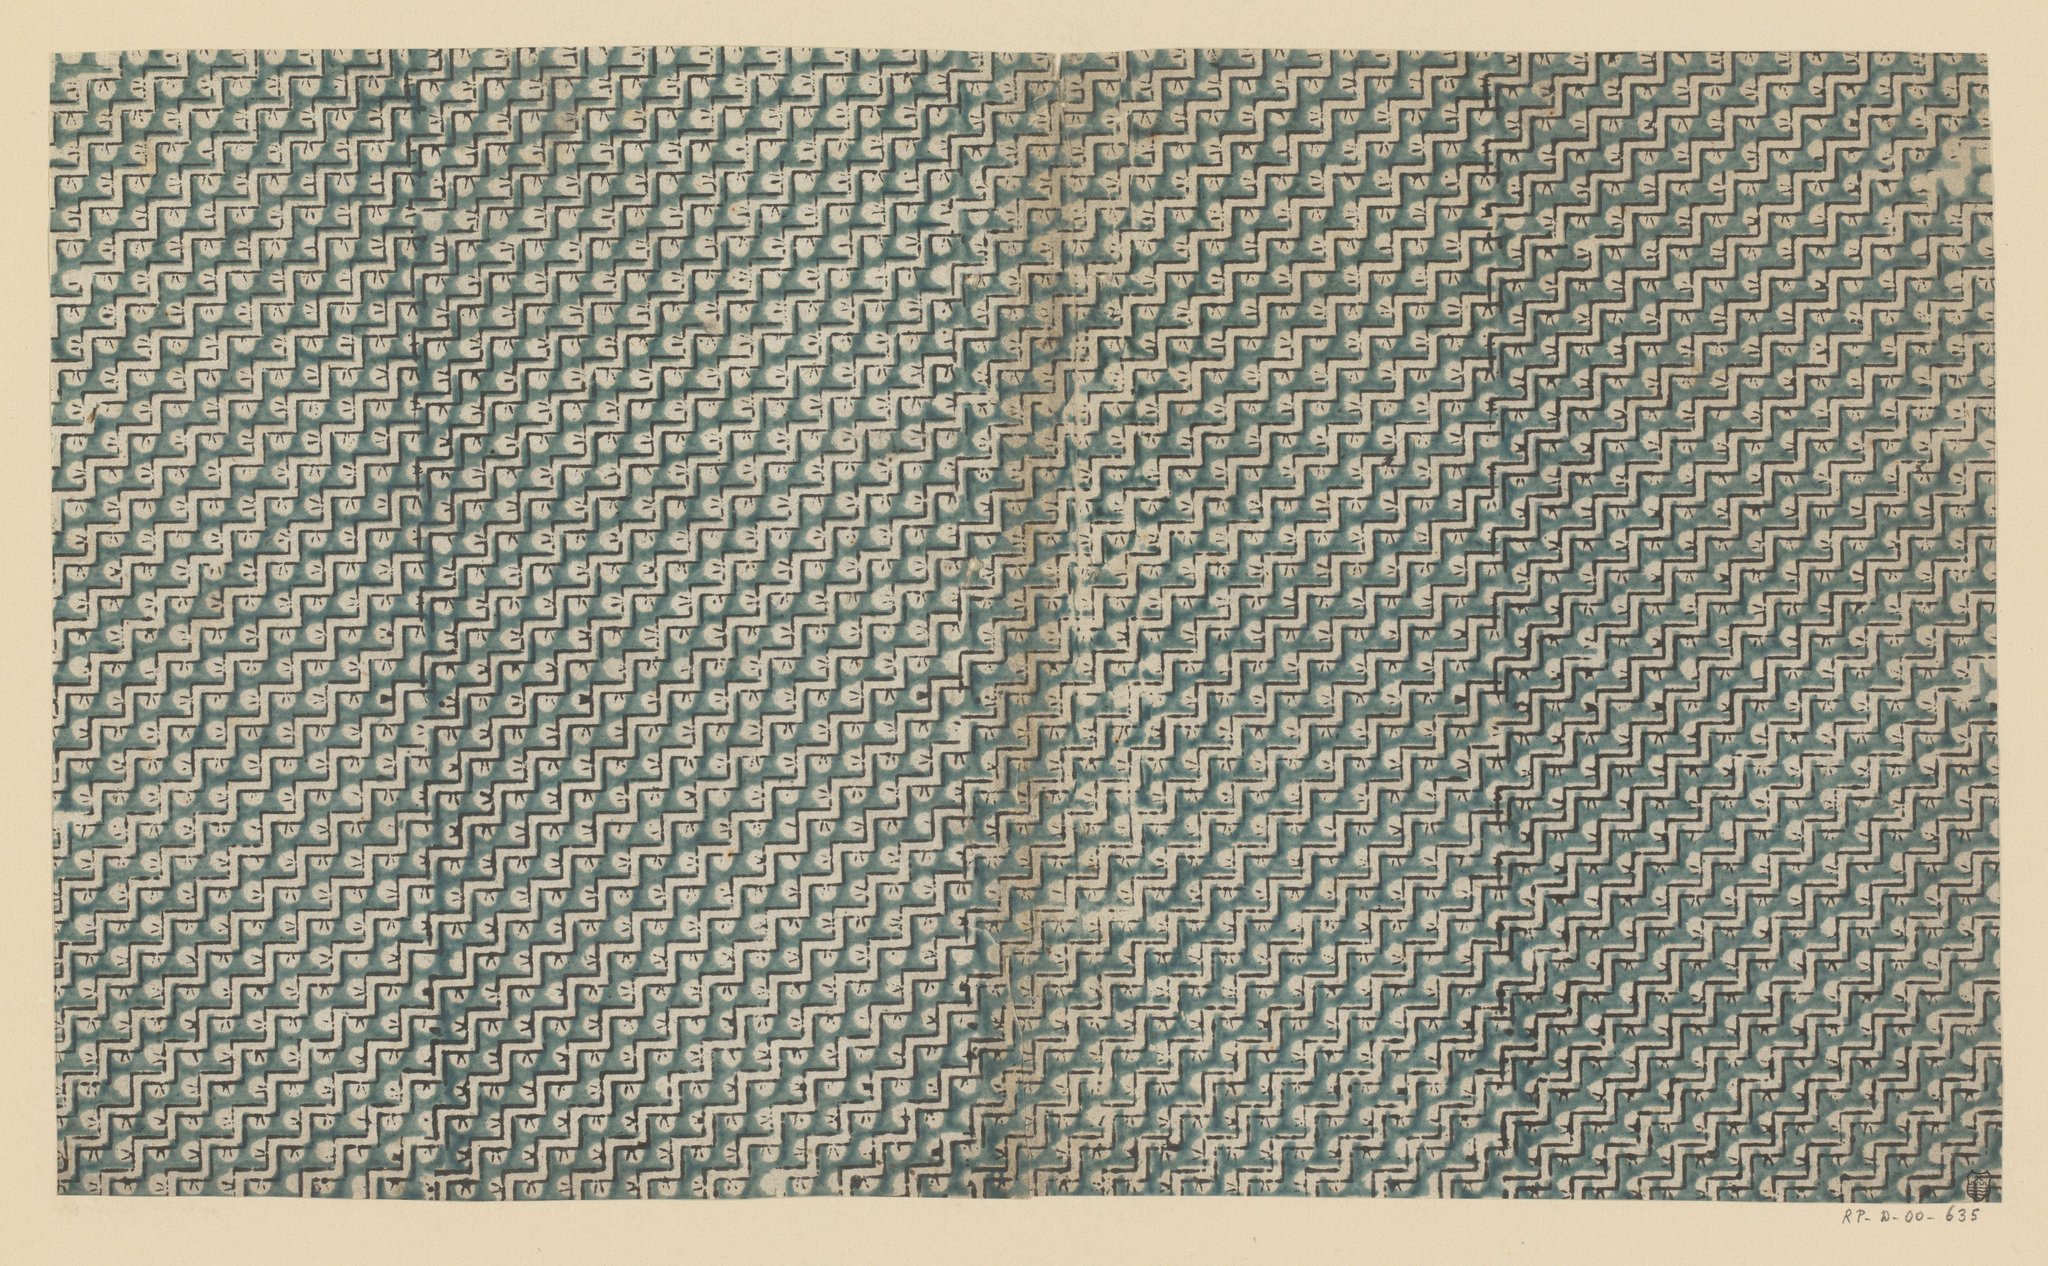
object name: wrapper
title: Blad met banenpatroon van trapmotief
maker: Anonymous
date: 1750-1900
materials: paper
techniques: printing block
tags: ornament ~ geometric motifs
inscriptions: collector's mark: Lugt 2760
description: Blad met diagonaal banenpatroon van trapmotief. Gebruikt als omslag.